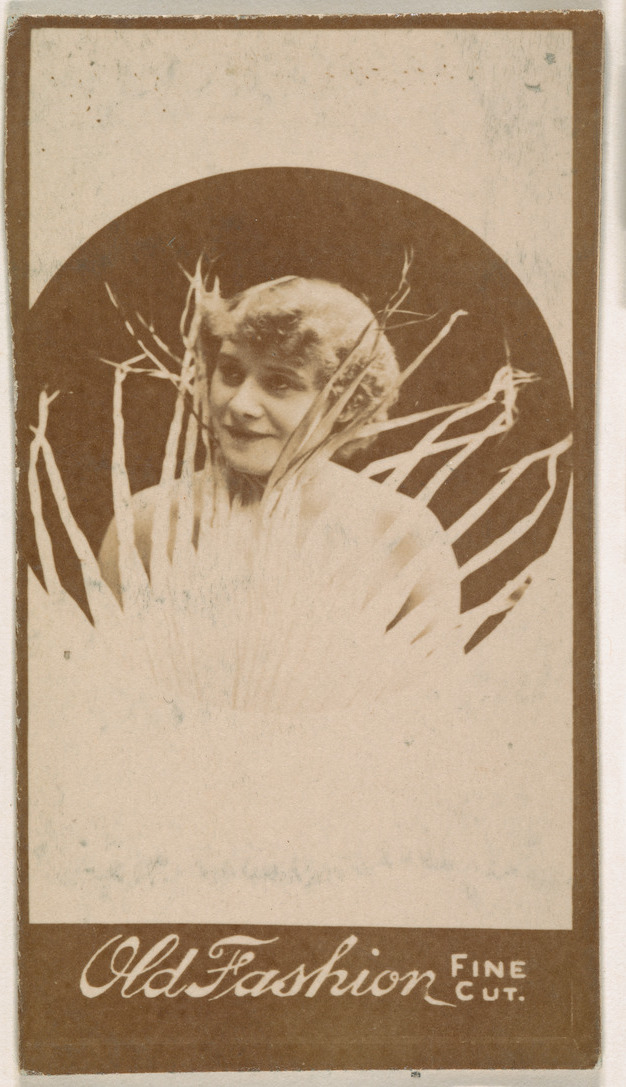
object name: photograph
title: Actress posing behind reeds, from the Actresses series (N664) promoting Old Fashion Fine Cut Tobacco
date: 1888-1890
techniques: albumen silver print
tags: portraits,women,actresses